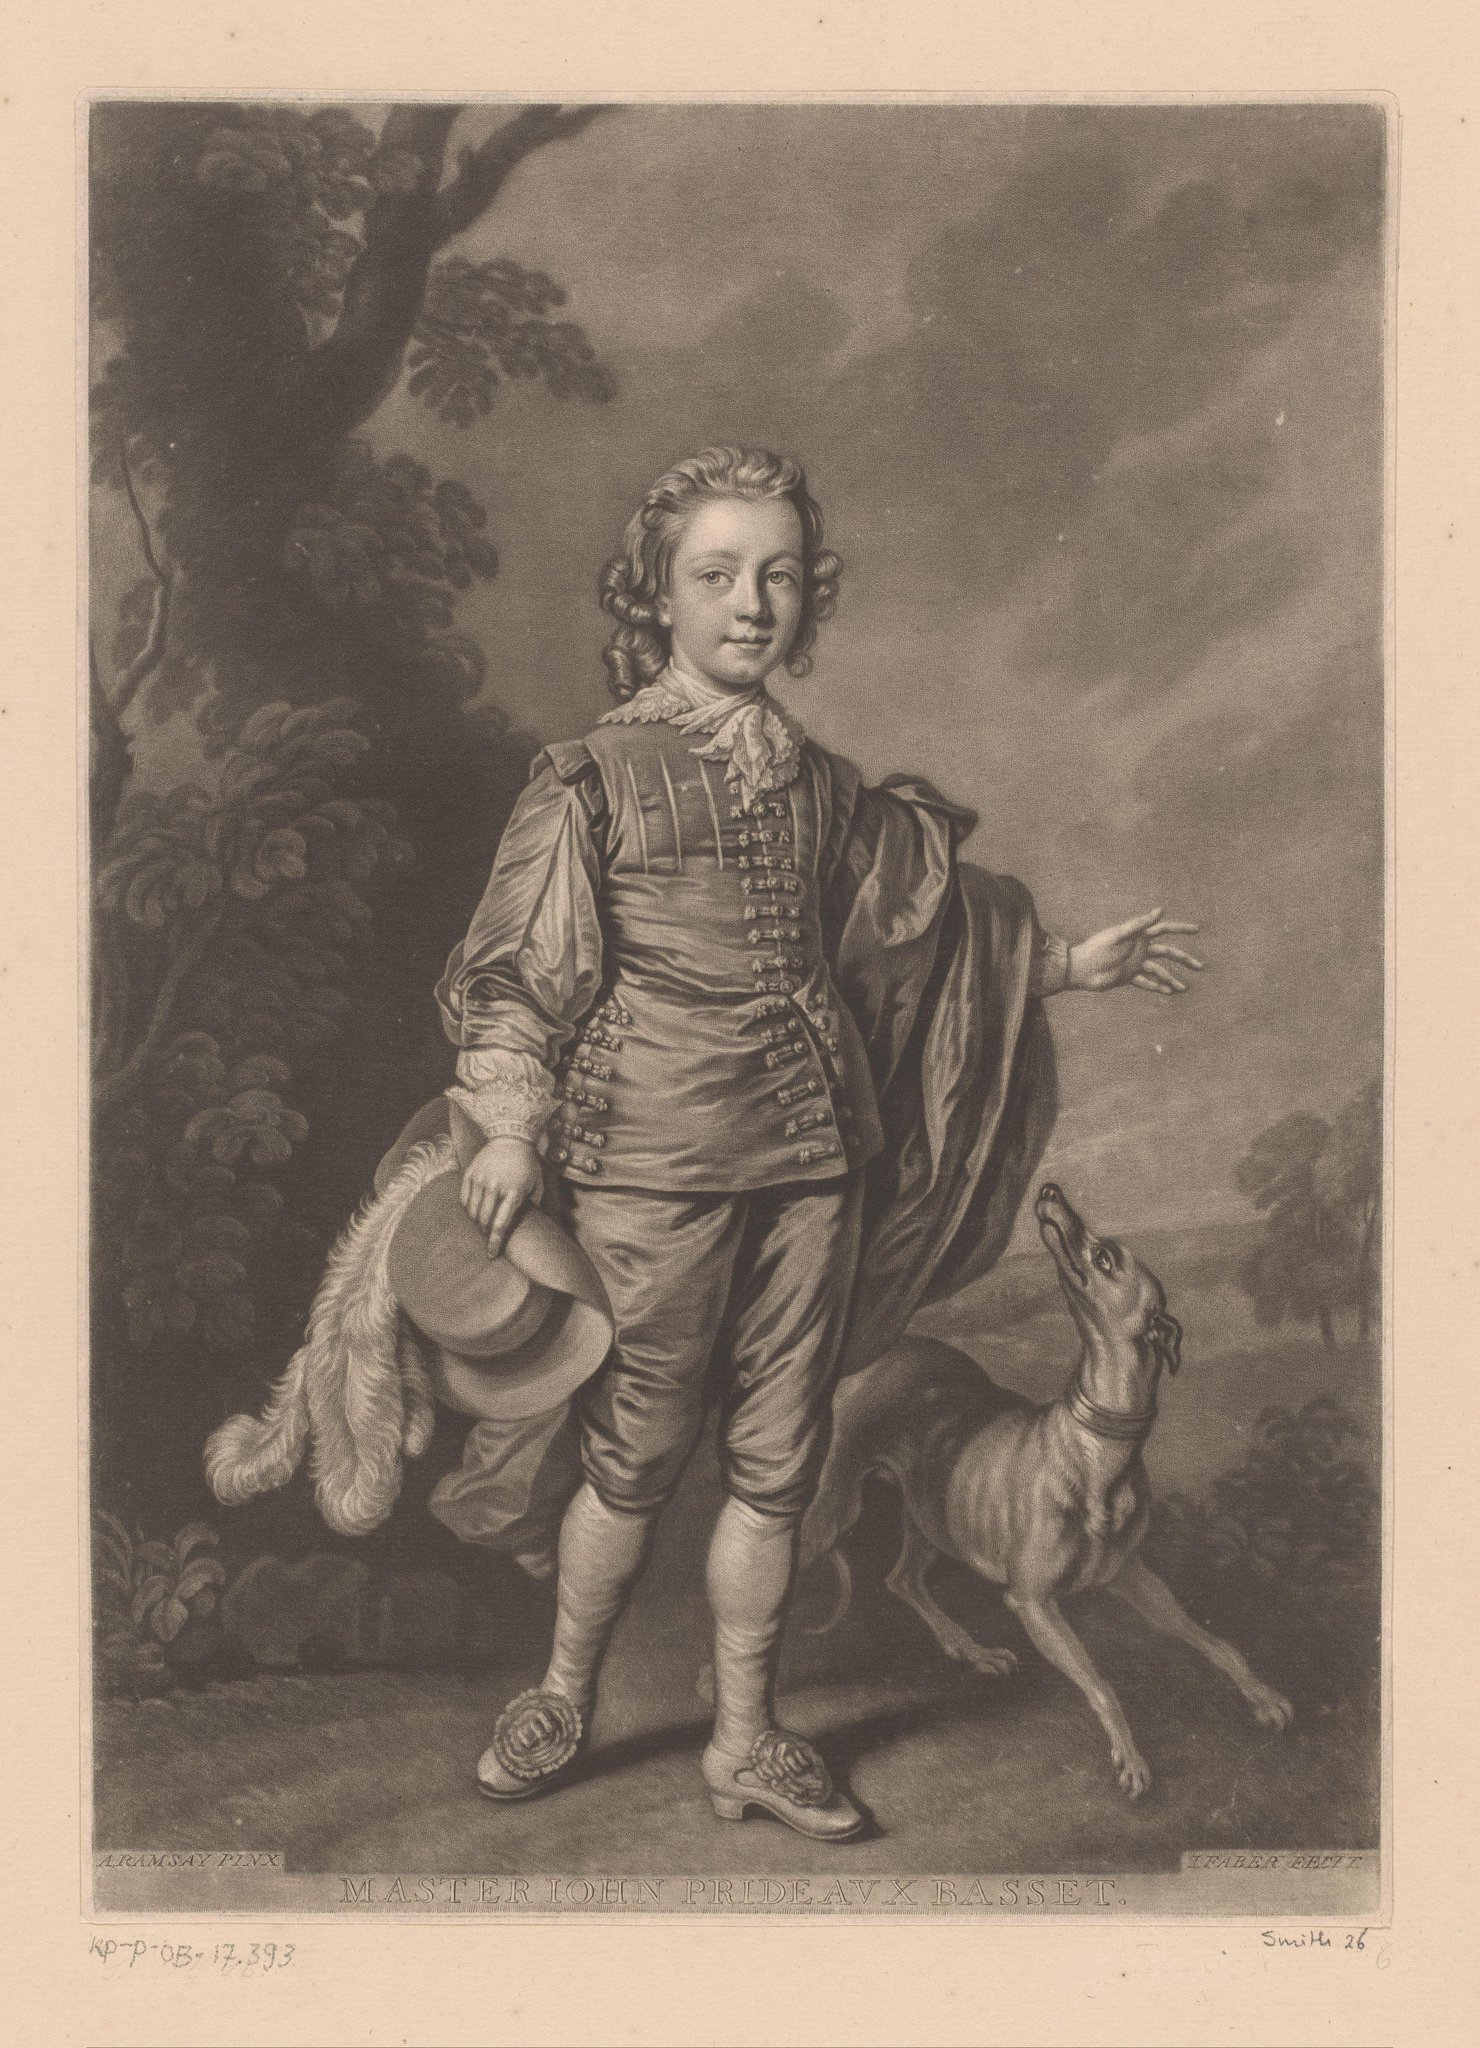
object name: print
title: Master Iohn Prideaux Basset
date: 1754-1756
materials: paper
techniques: etching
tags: historical persons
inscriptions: collector's mark: Lugt 240